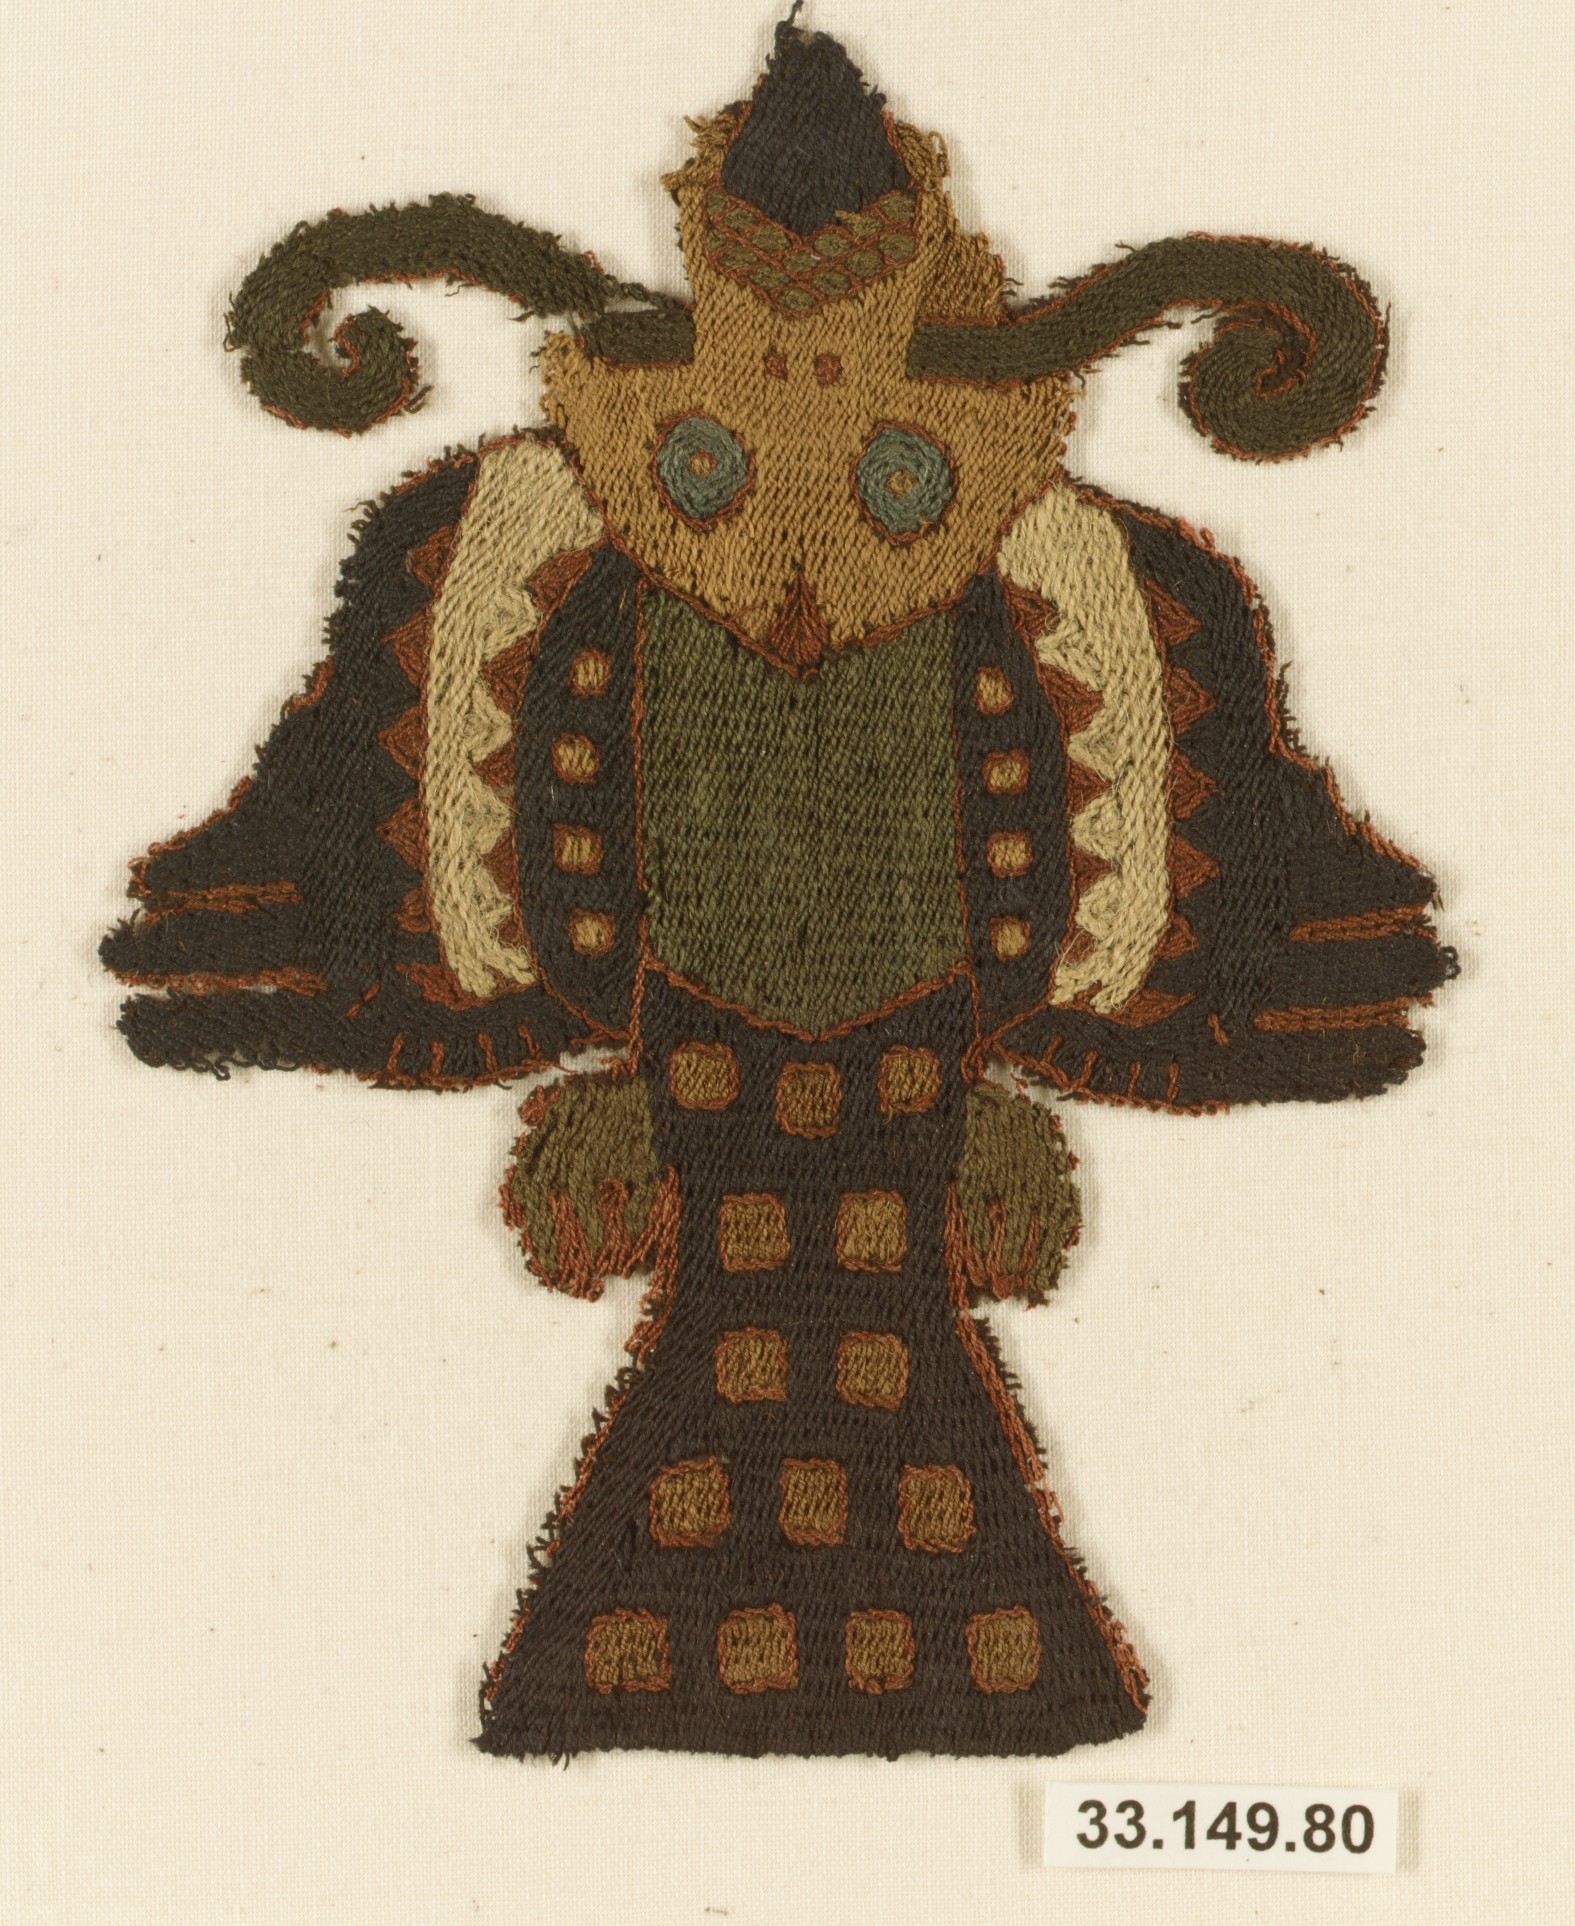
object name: textile fragment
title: Embroidered Fragment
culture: paracas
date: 400-201 BCE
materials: animal fiber, cotton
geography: peru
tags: birds